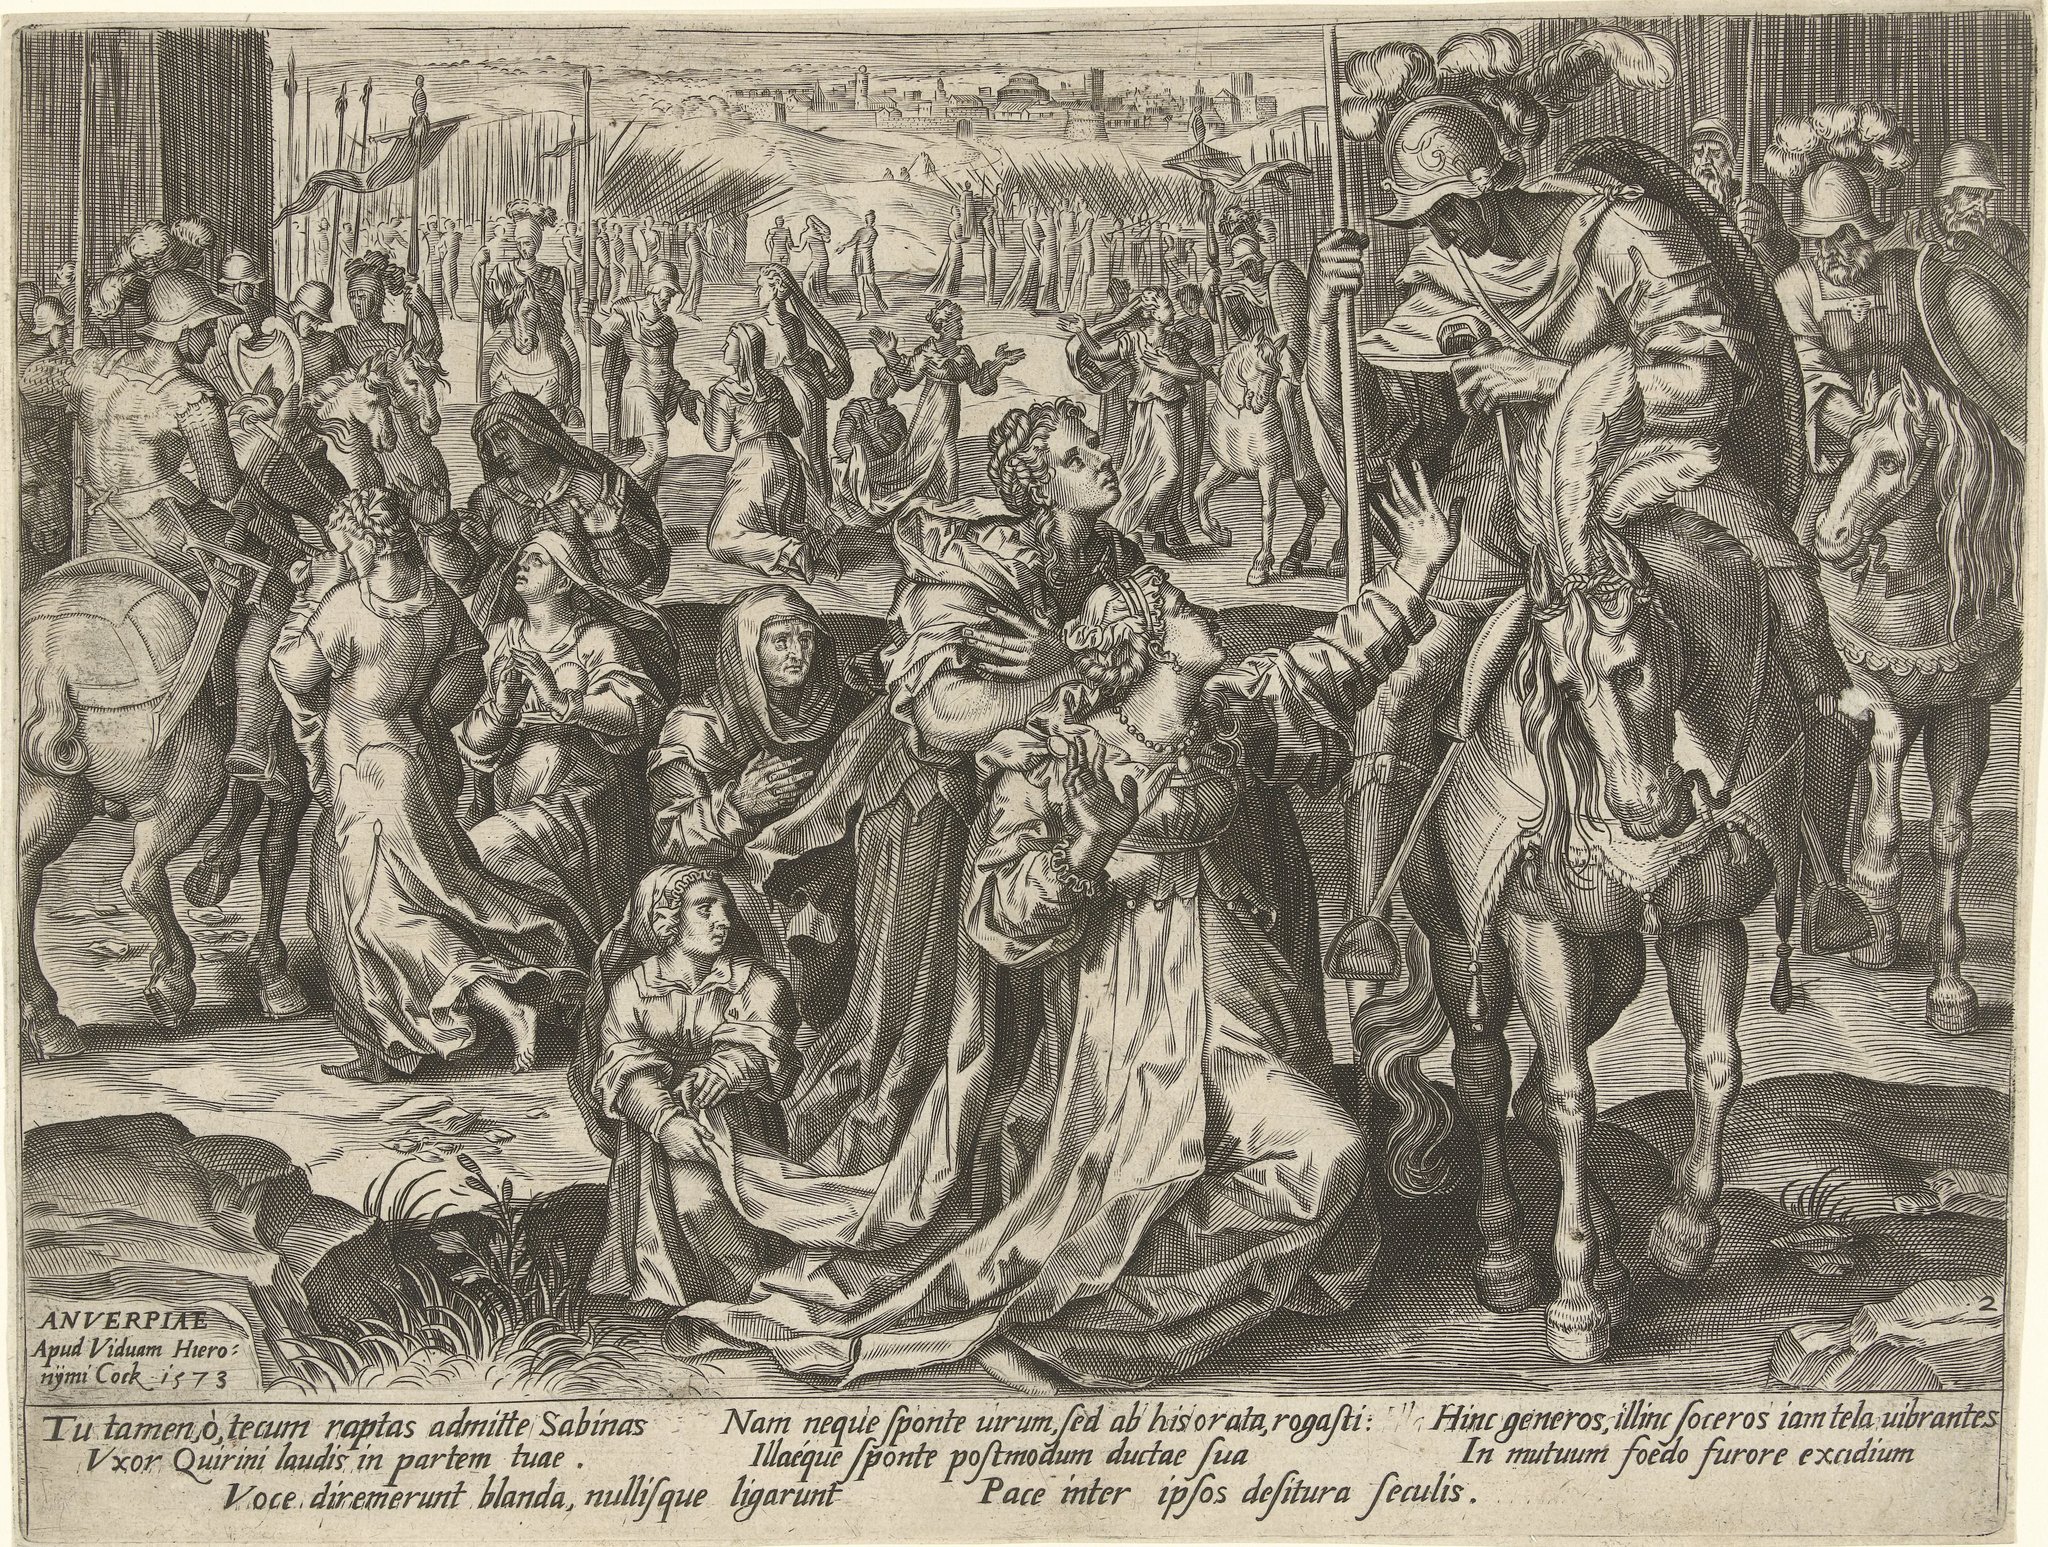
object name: print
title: Voorstellingen uit de Romeinse geschiedenis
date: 1573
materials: paper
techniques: engraving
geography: antwerp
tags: (story of) the sabine women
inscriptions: inscription, collector's mark: Lugt 240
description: De Sabijnse vrouwen zijn neergeknield bij Romeinse en Sabijnse soldaten te paard en smeken hen de strijd te staken. In de marge onder de voorstelling staat een tekst in het Latijn, rechtsonder genummerd: 2. De prent maakt deel uit van een serie prenten die gebeurtenissen uit de Romeinse geschiedenis verbeelden.